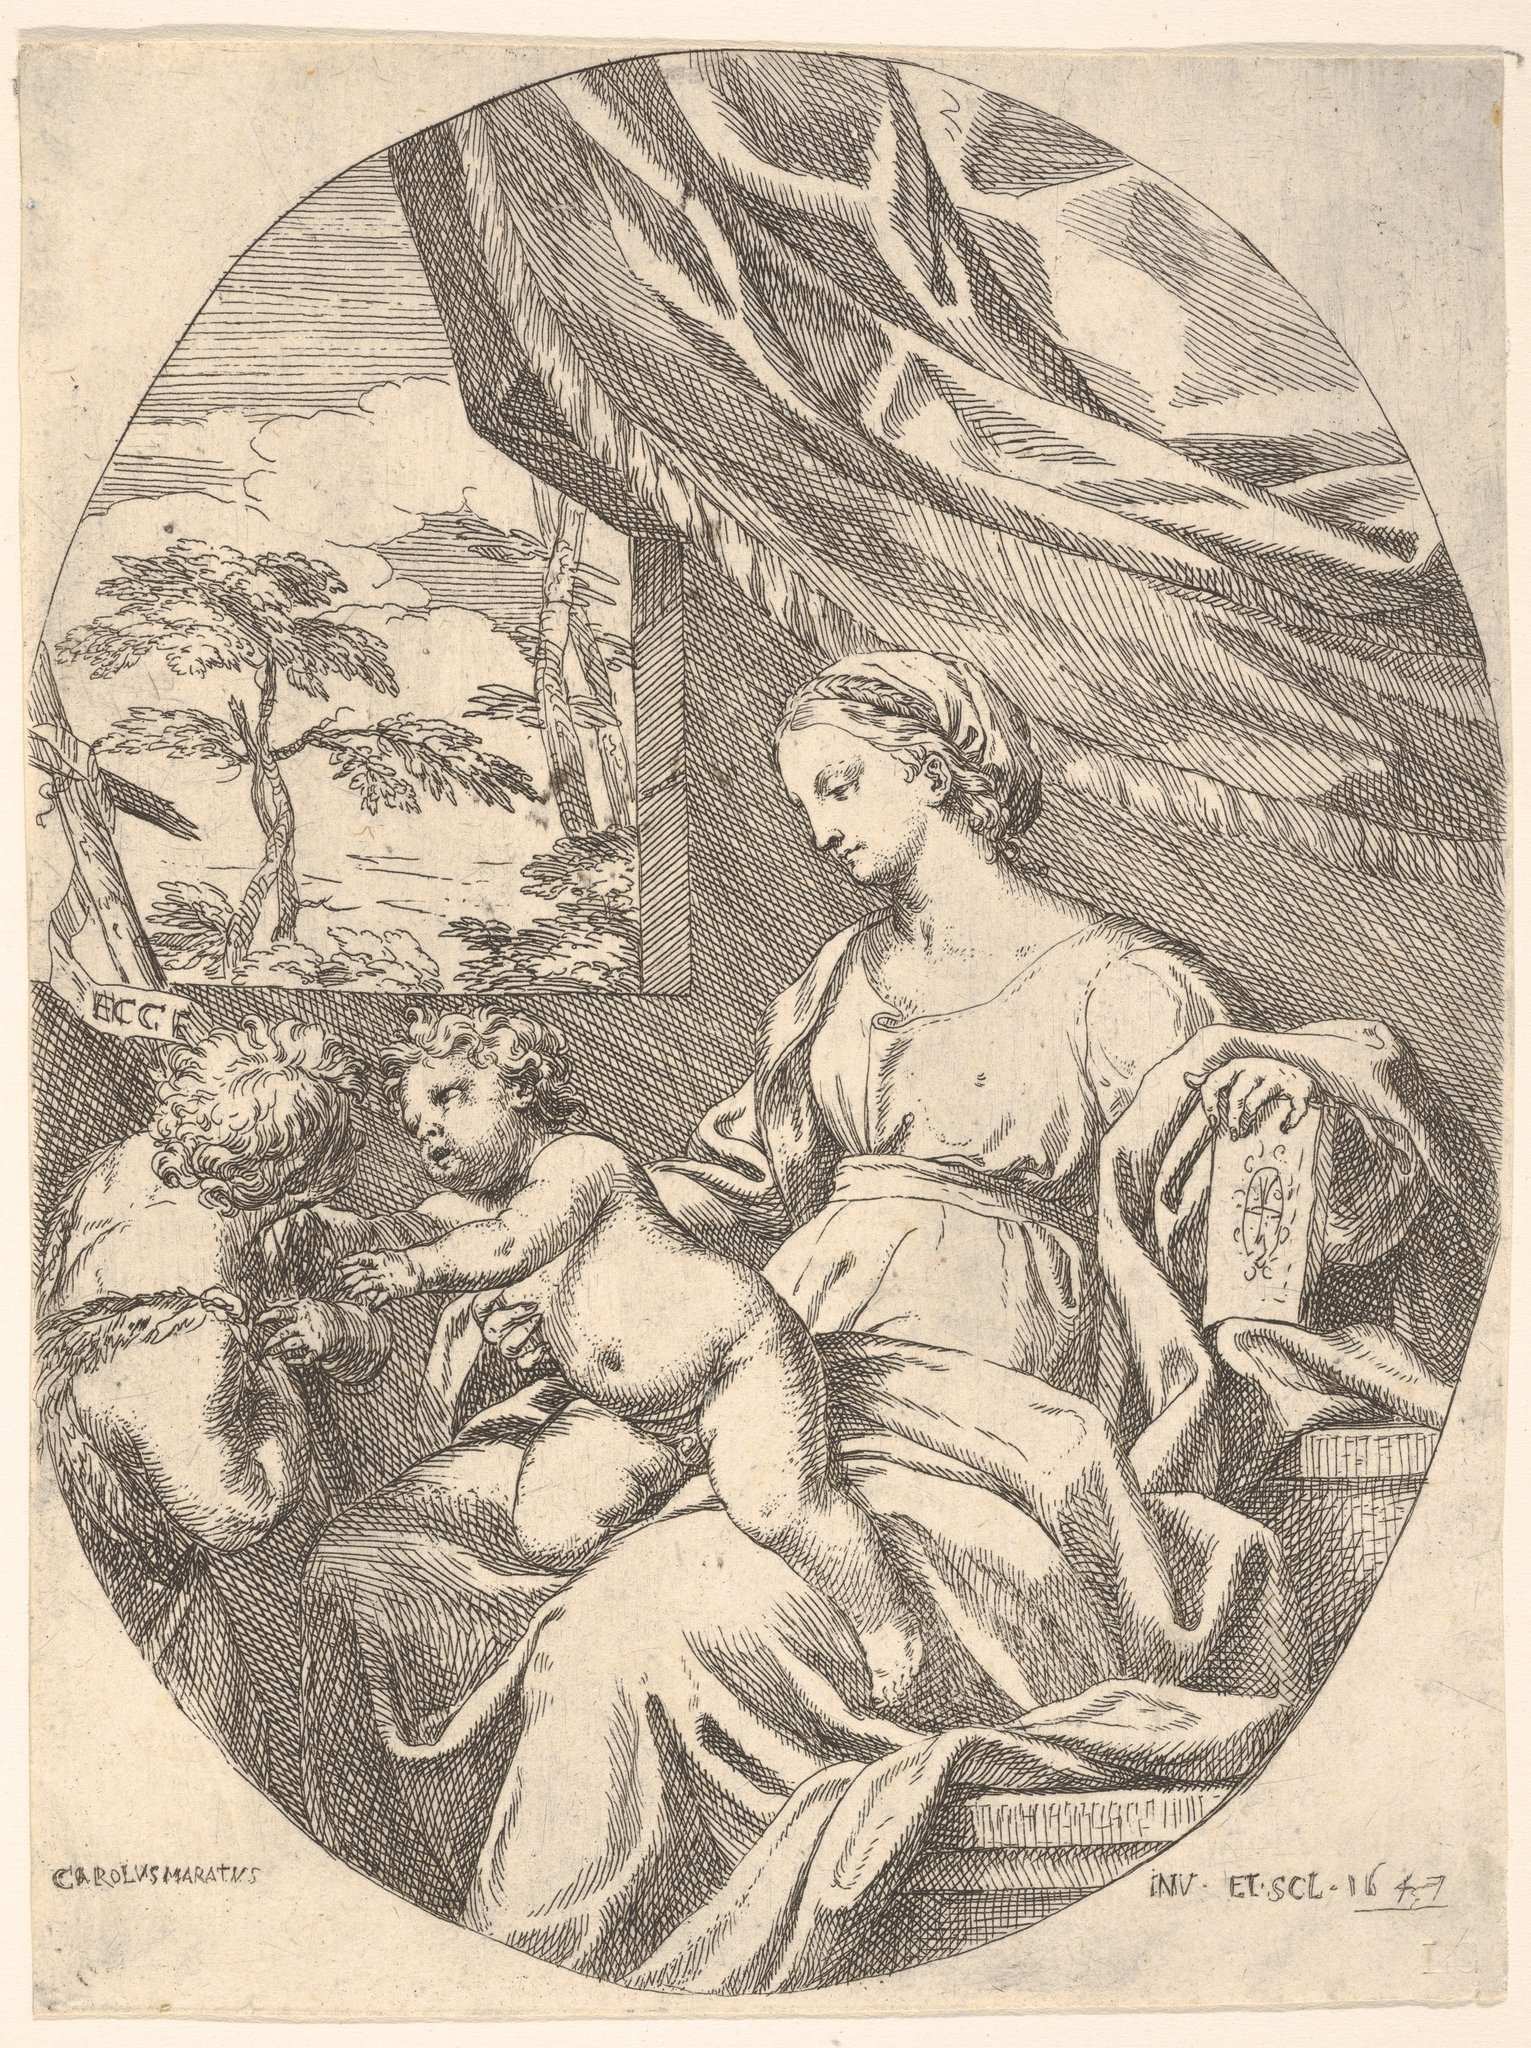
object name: print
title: Seated Virgin and Child with Saint John the Baptist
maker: carlo maratti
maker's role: artist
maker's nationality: italian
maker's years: 1625-1713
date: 1647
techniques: etching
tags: books,madonna and child,saint john the baptist